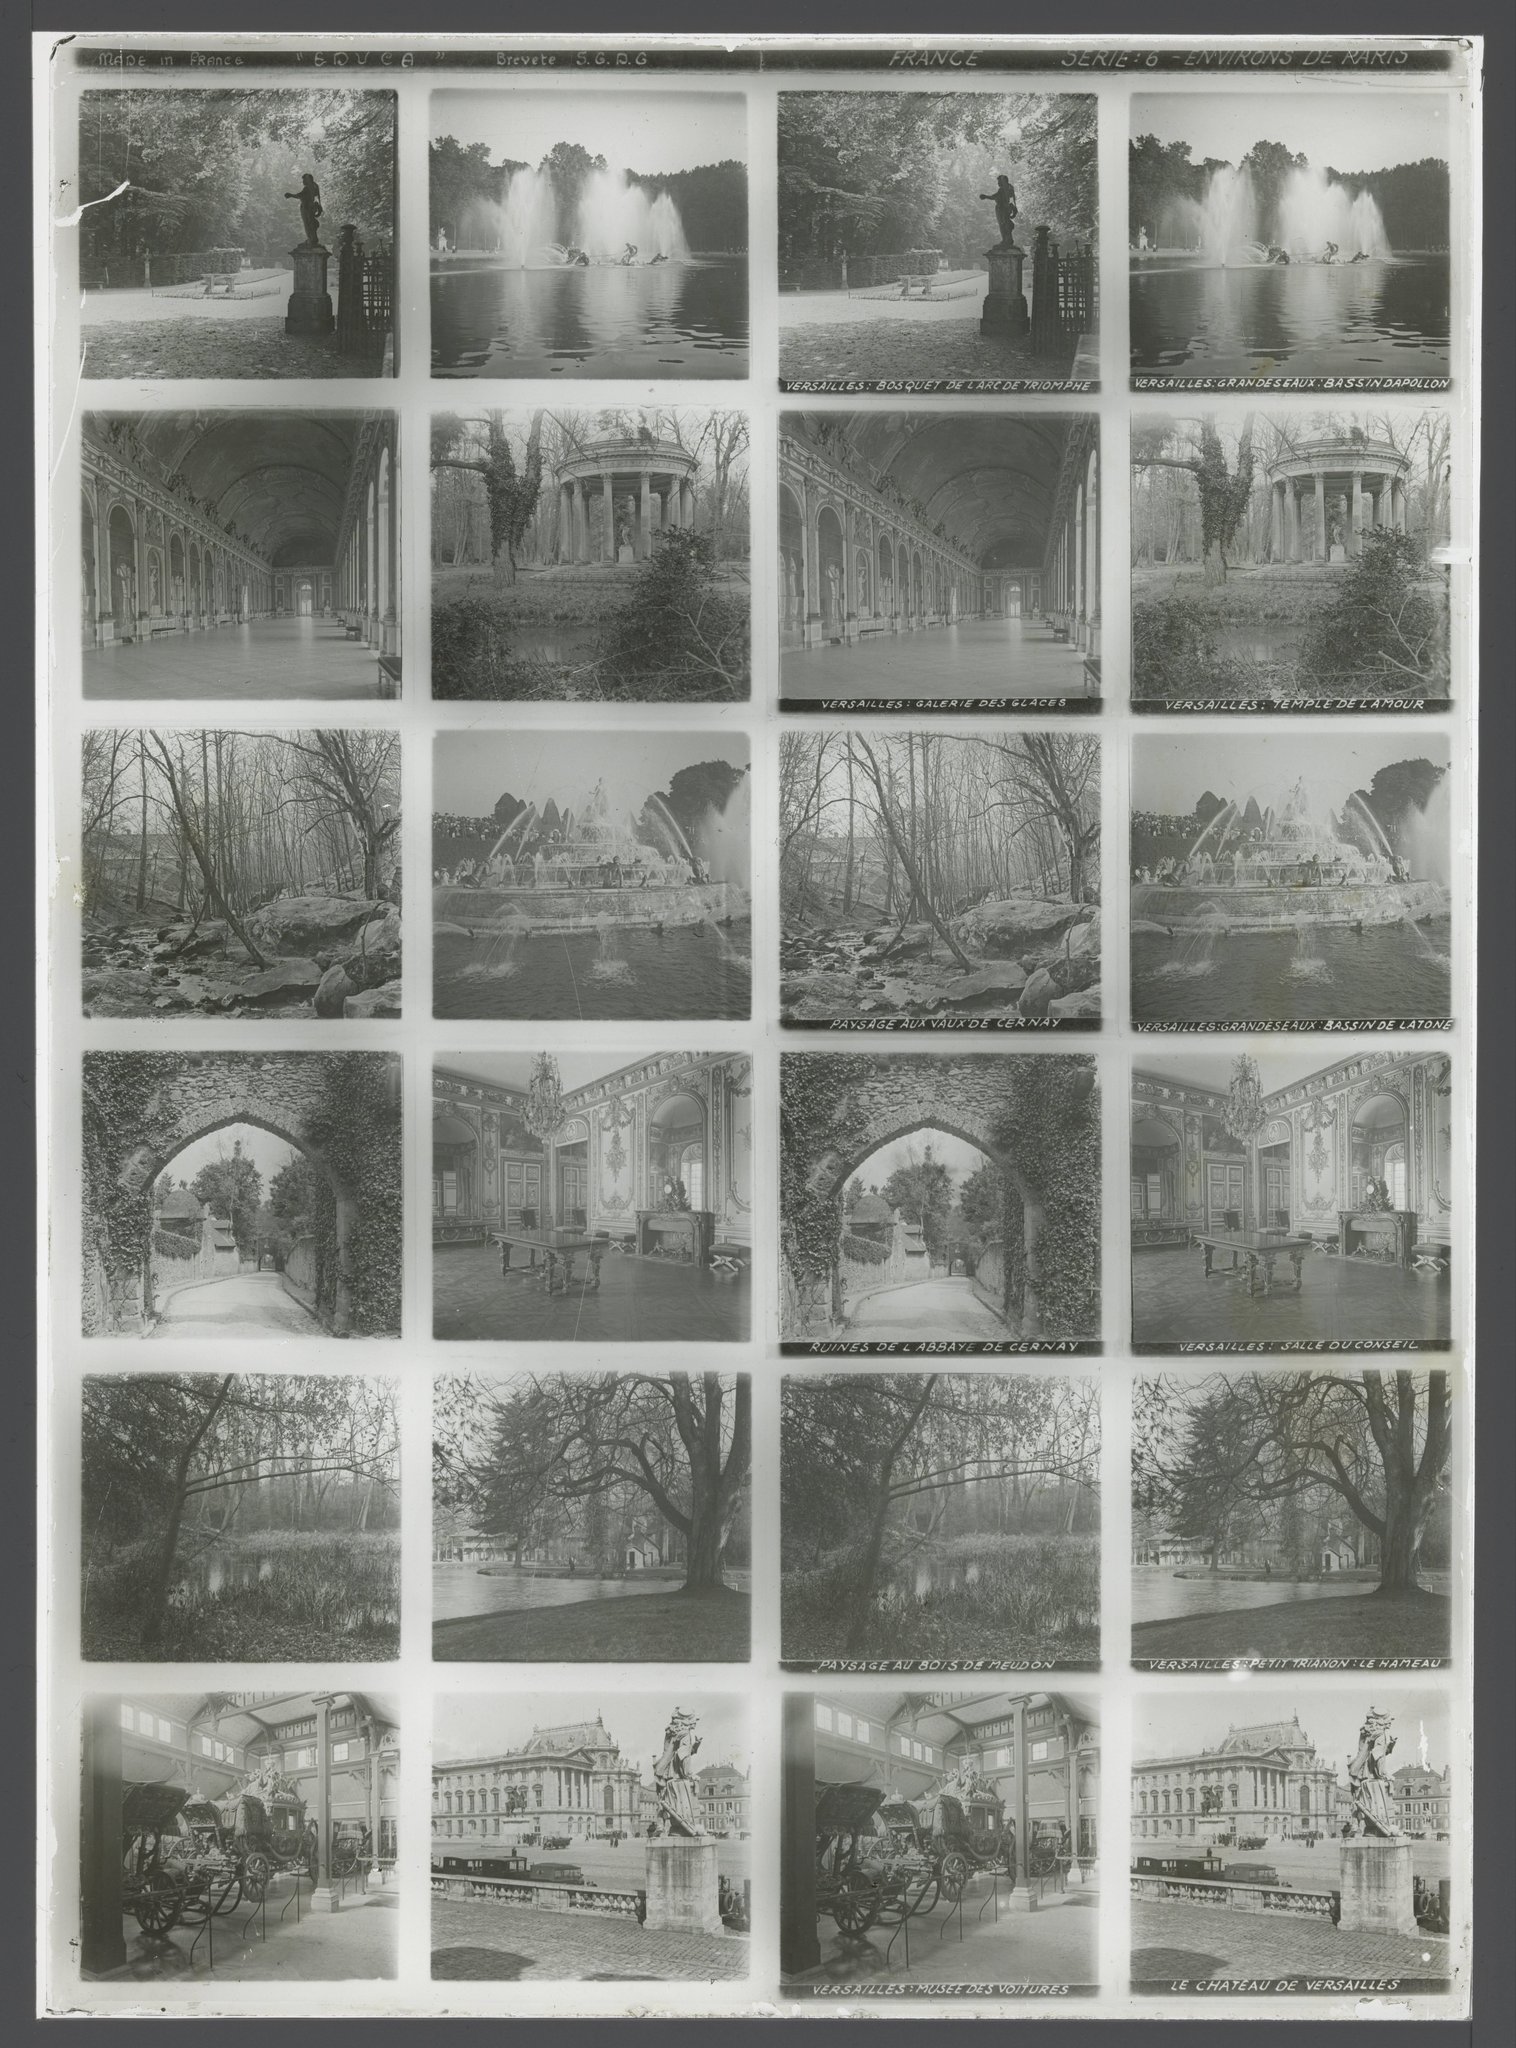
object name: stereoscopic photograph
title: Twaalf stereoscopische opnamen van Versailles en Meudon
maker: Anonymous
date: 1920-1925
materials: glass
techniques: gelatin silver transparency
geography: france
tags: palace, french or architectonic garden; formal garden, ornamental fountain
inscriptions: inscription: ‘Made in France (...) Brevete S.G.D.G. (...)’